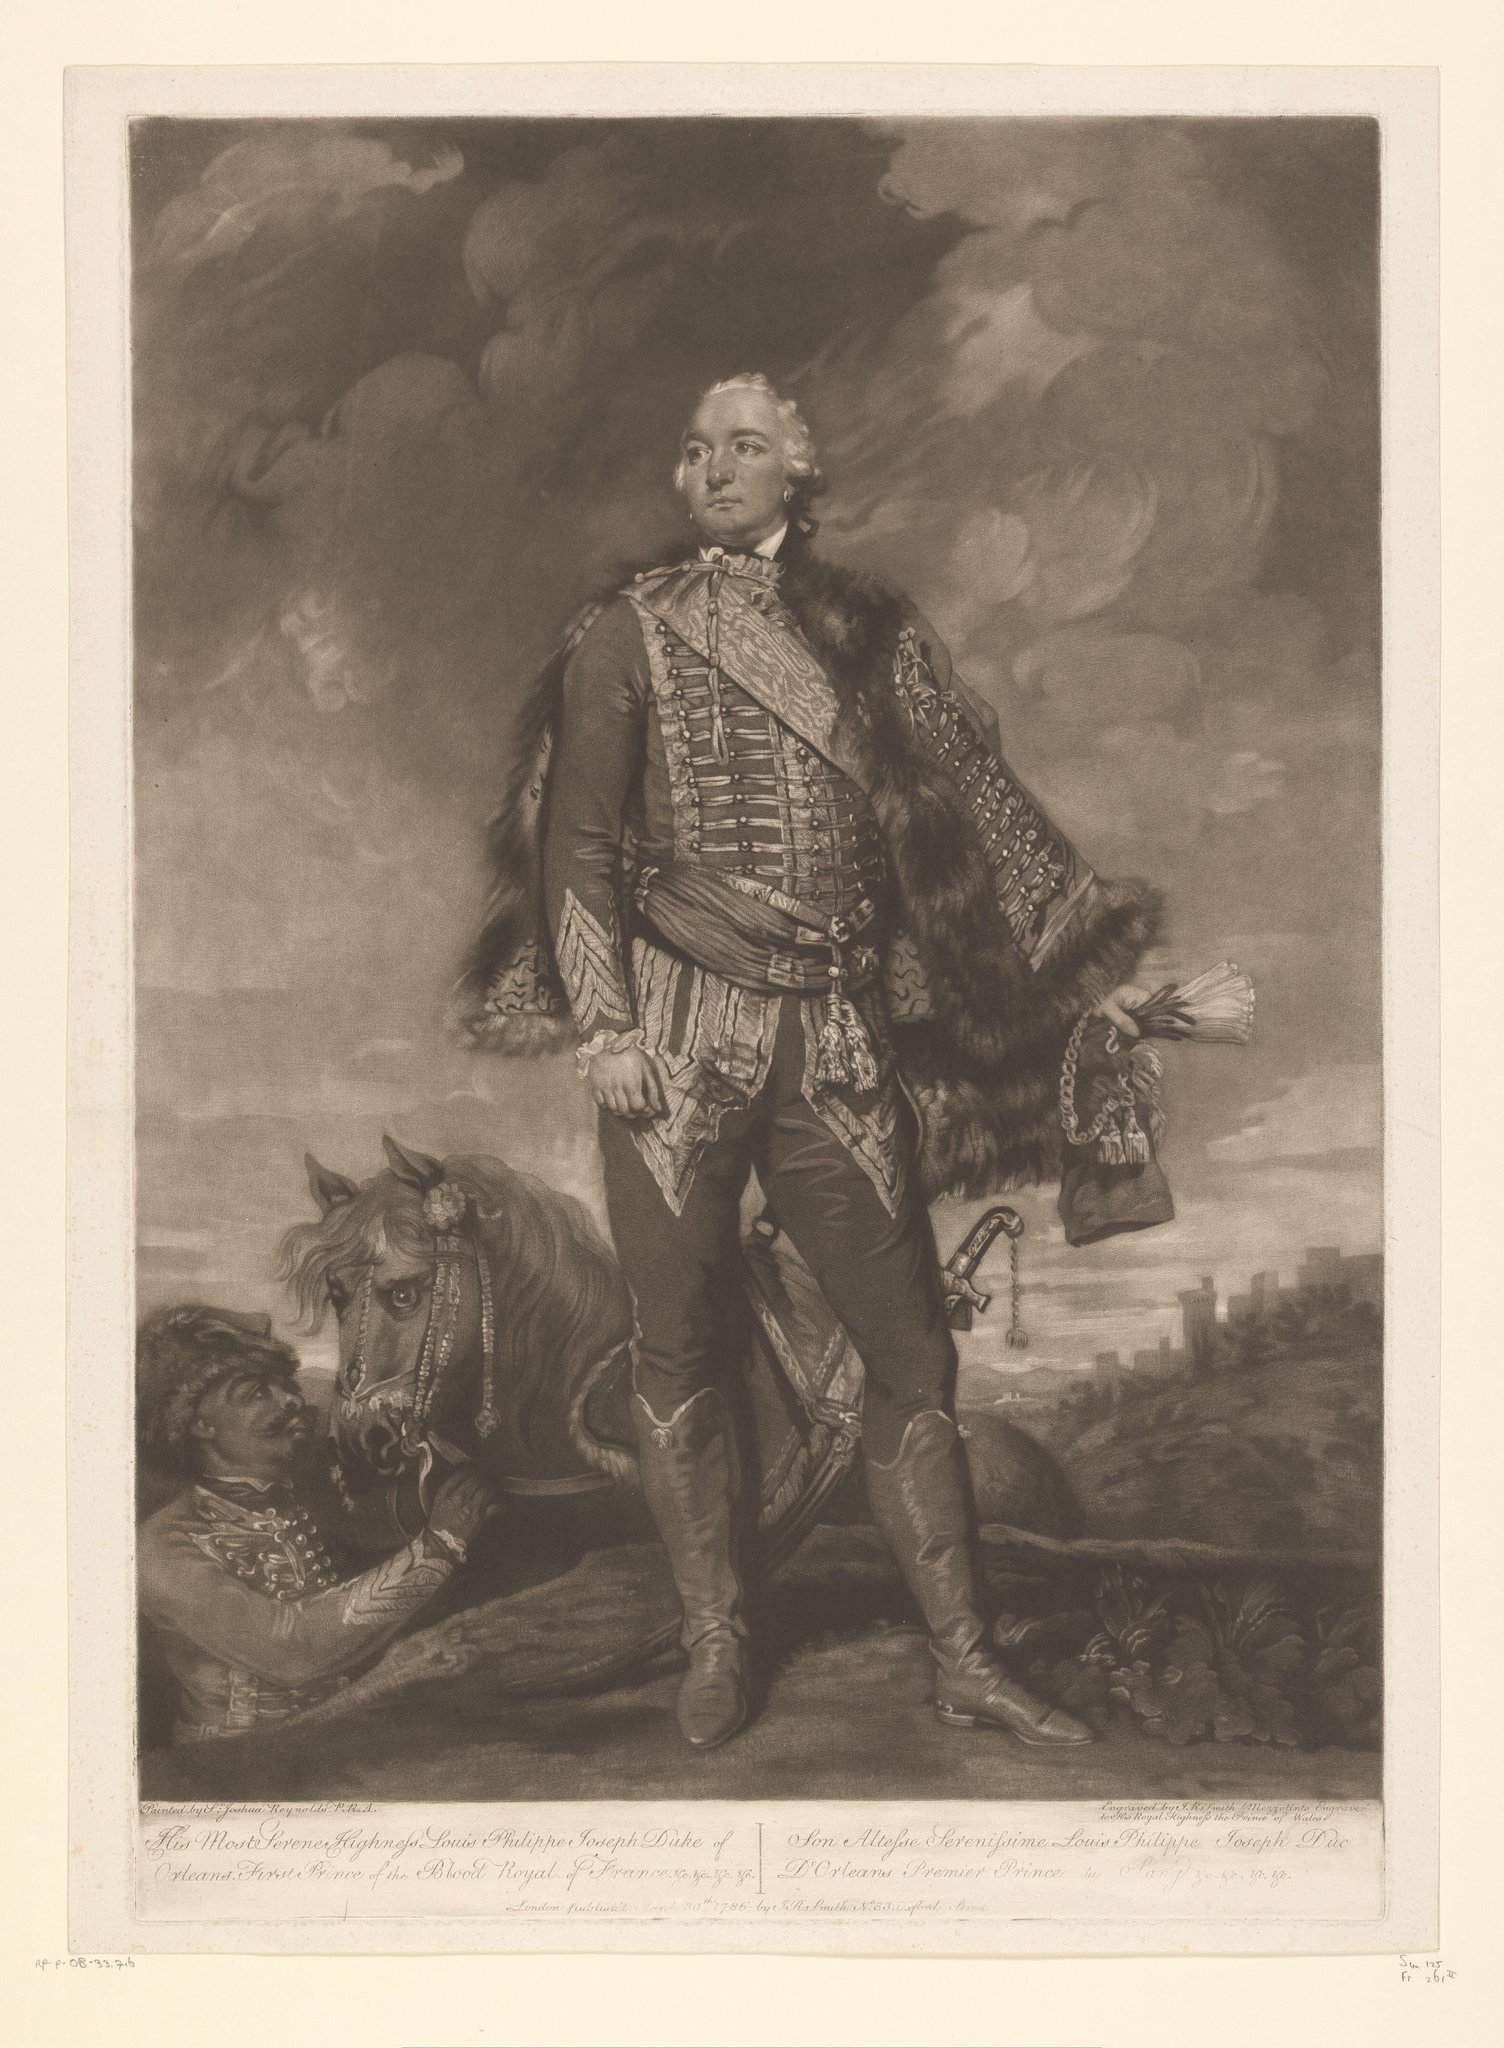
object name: print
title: Portret van Lodewijk Filips II van Orléans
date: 1703-1786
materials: paper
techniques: mezzotint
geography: london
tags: paris, lodewijk filips ii (hertog van orléans), historical persons, horse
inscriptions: collector's mark: Lugt 2228